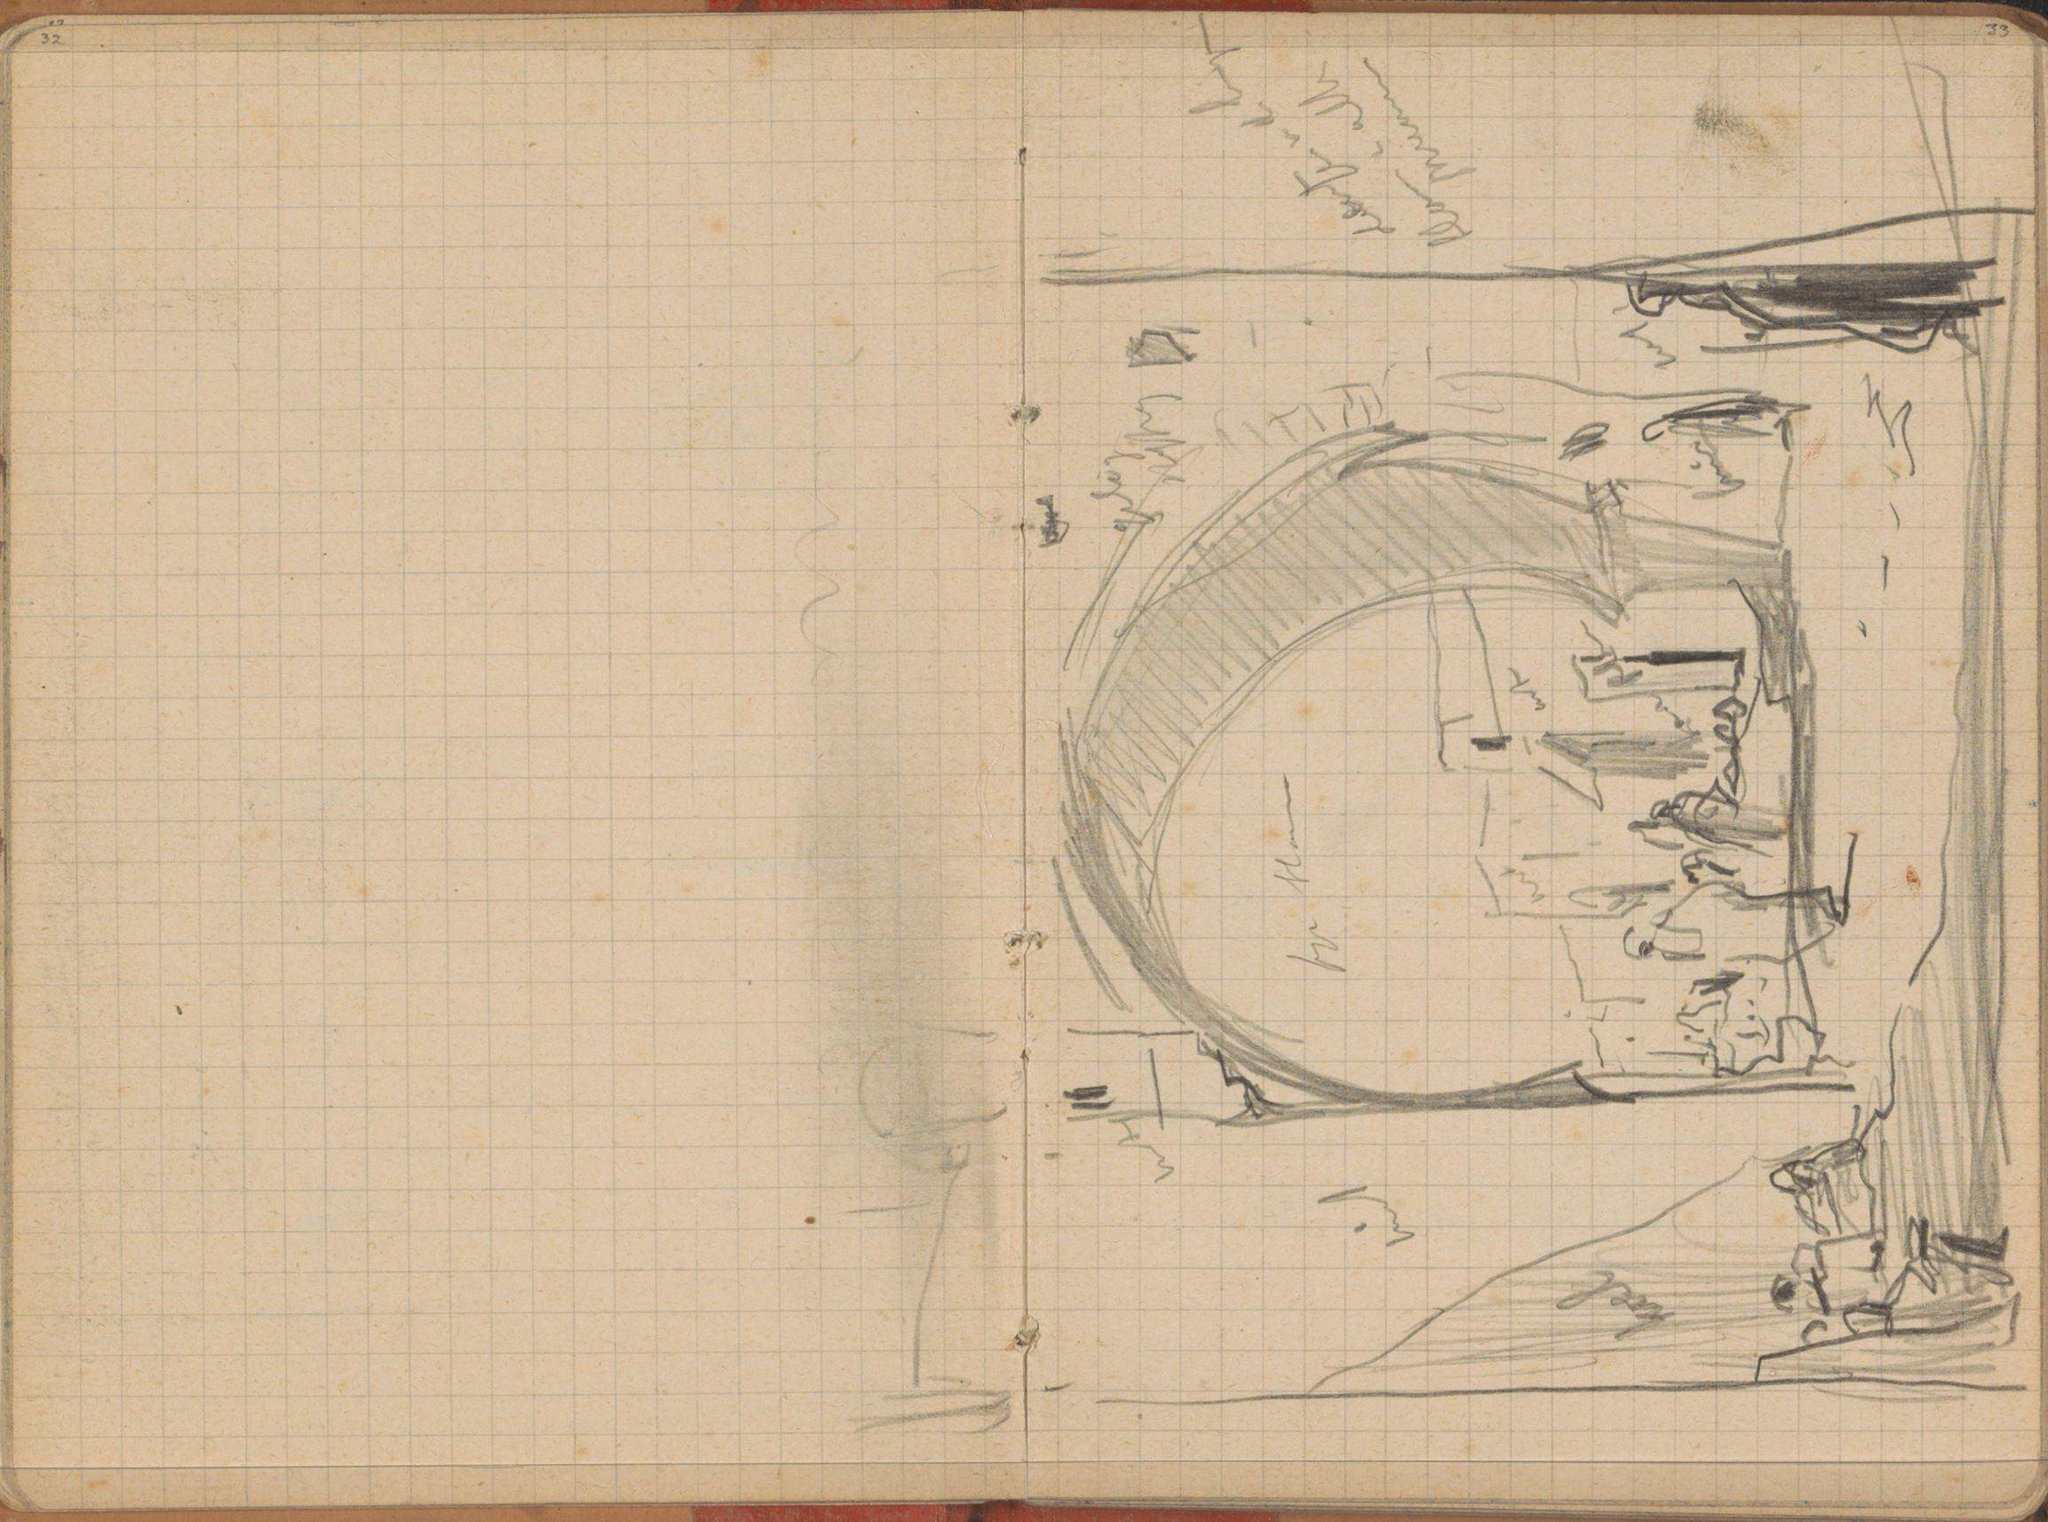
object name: sketchbook leaf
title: Bab el Bahr poort in Tunis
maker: marius bauer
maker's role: draughtsman, print maker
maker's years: 1867-1932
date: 1909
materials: pencil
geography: tunis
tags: gate, entrance, street (+ city(-scape) with figures, staffage)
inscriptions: kleurnotitie, handgeschreven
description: Pagina 32 en 33 uit een schetsboek met 67 bladen.